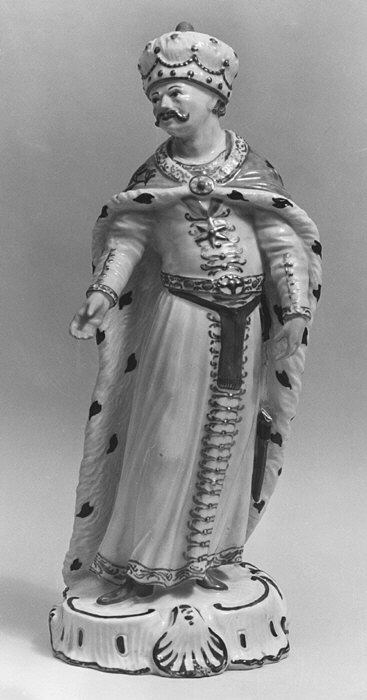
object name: figure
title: Asia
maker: limbach porcelain manufactory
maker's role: manufactory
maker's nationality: german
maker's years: 1762-1939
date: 1775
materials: hard paste porcelain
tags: men,portraits